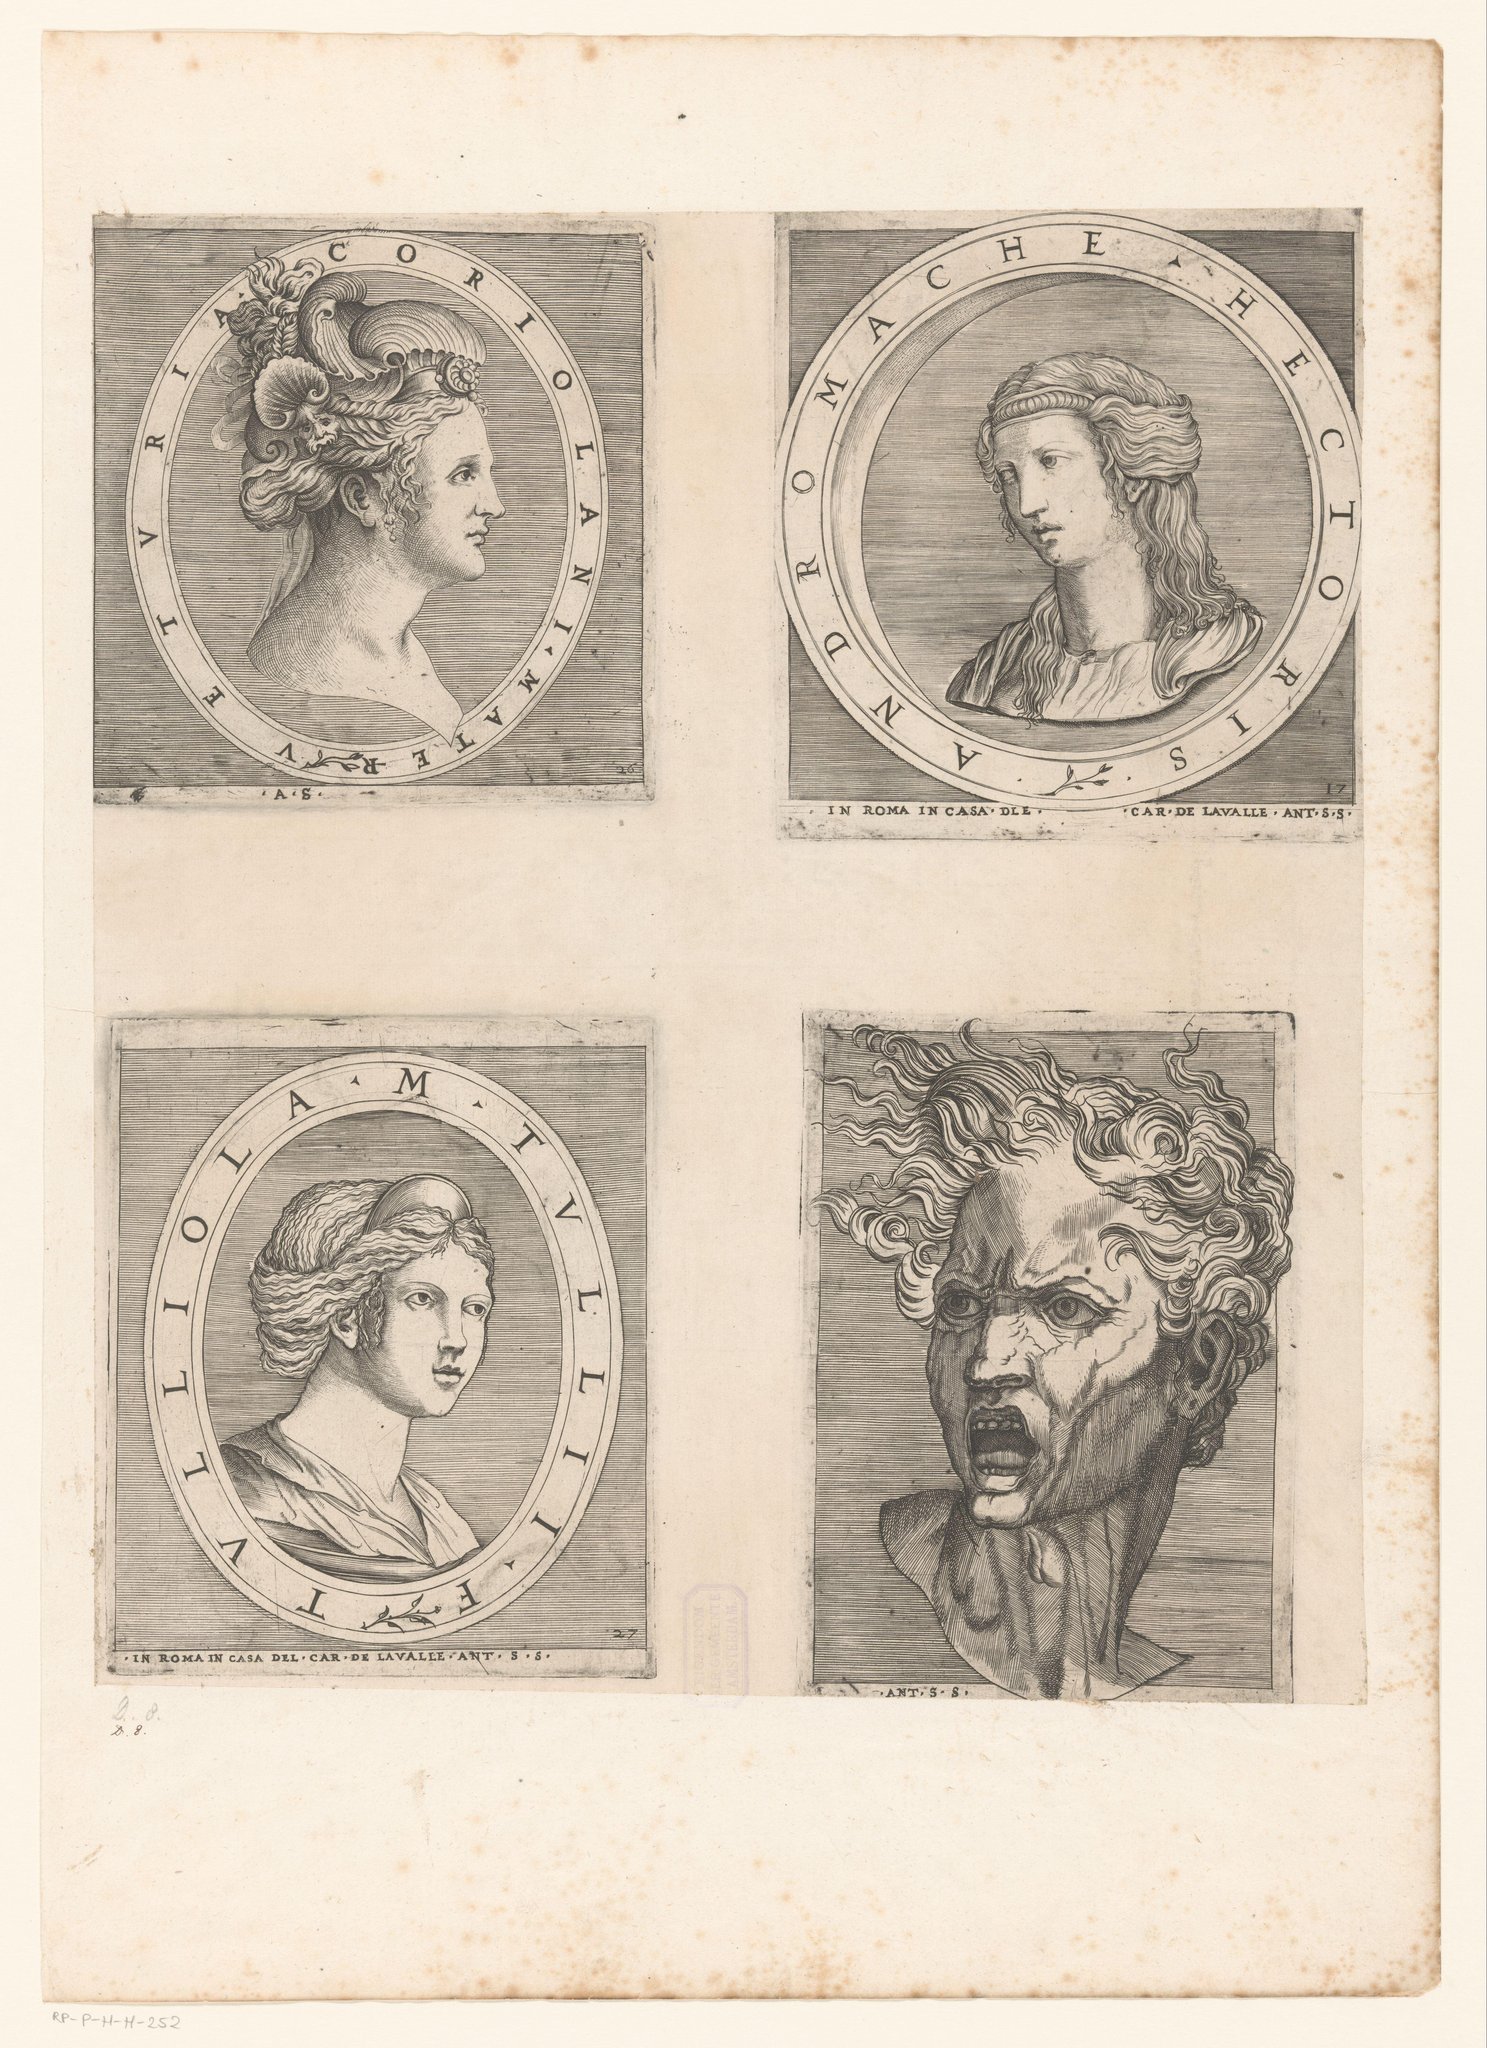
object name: print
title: Veturia Coriolani Mater/ Andromache Hectoris/ Tulliola M. Tullii F.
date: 1510-1562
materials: paper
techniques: engraving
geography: italy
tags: historical persons - bb - woman, furies, dirae (erinyes), eumenides; 'furie' (ripa), piece of sculpture, reproduction of a piece of sculpture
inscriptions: collector's mark: Lugt 11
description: Blad met drie voorstellingen van medaillons met vrouwenkoppen en een vierde voorstelling van een furie. Linksboven: buste van Veturia Coriolani Mater. Genummerd rechtsonder: 26. Rechtsboven: buste van Andromache Hectoris. Genummerd rechtsonder: 17. Linksonder: portretbuste van Tulliola M. Tullii F.. Genummerd rechtsonder: 27. Rechtsonder: een kop van een schreeuwende furie met wapperend haar.